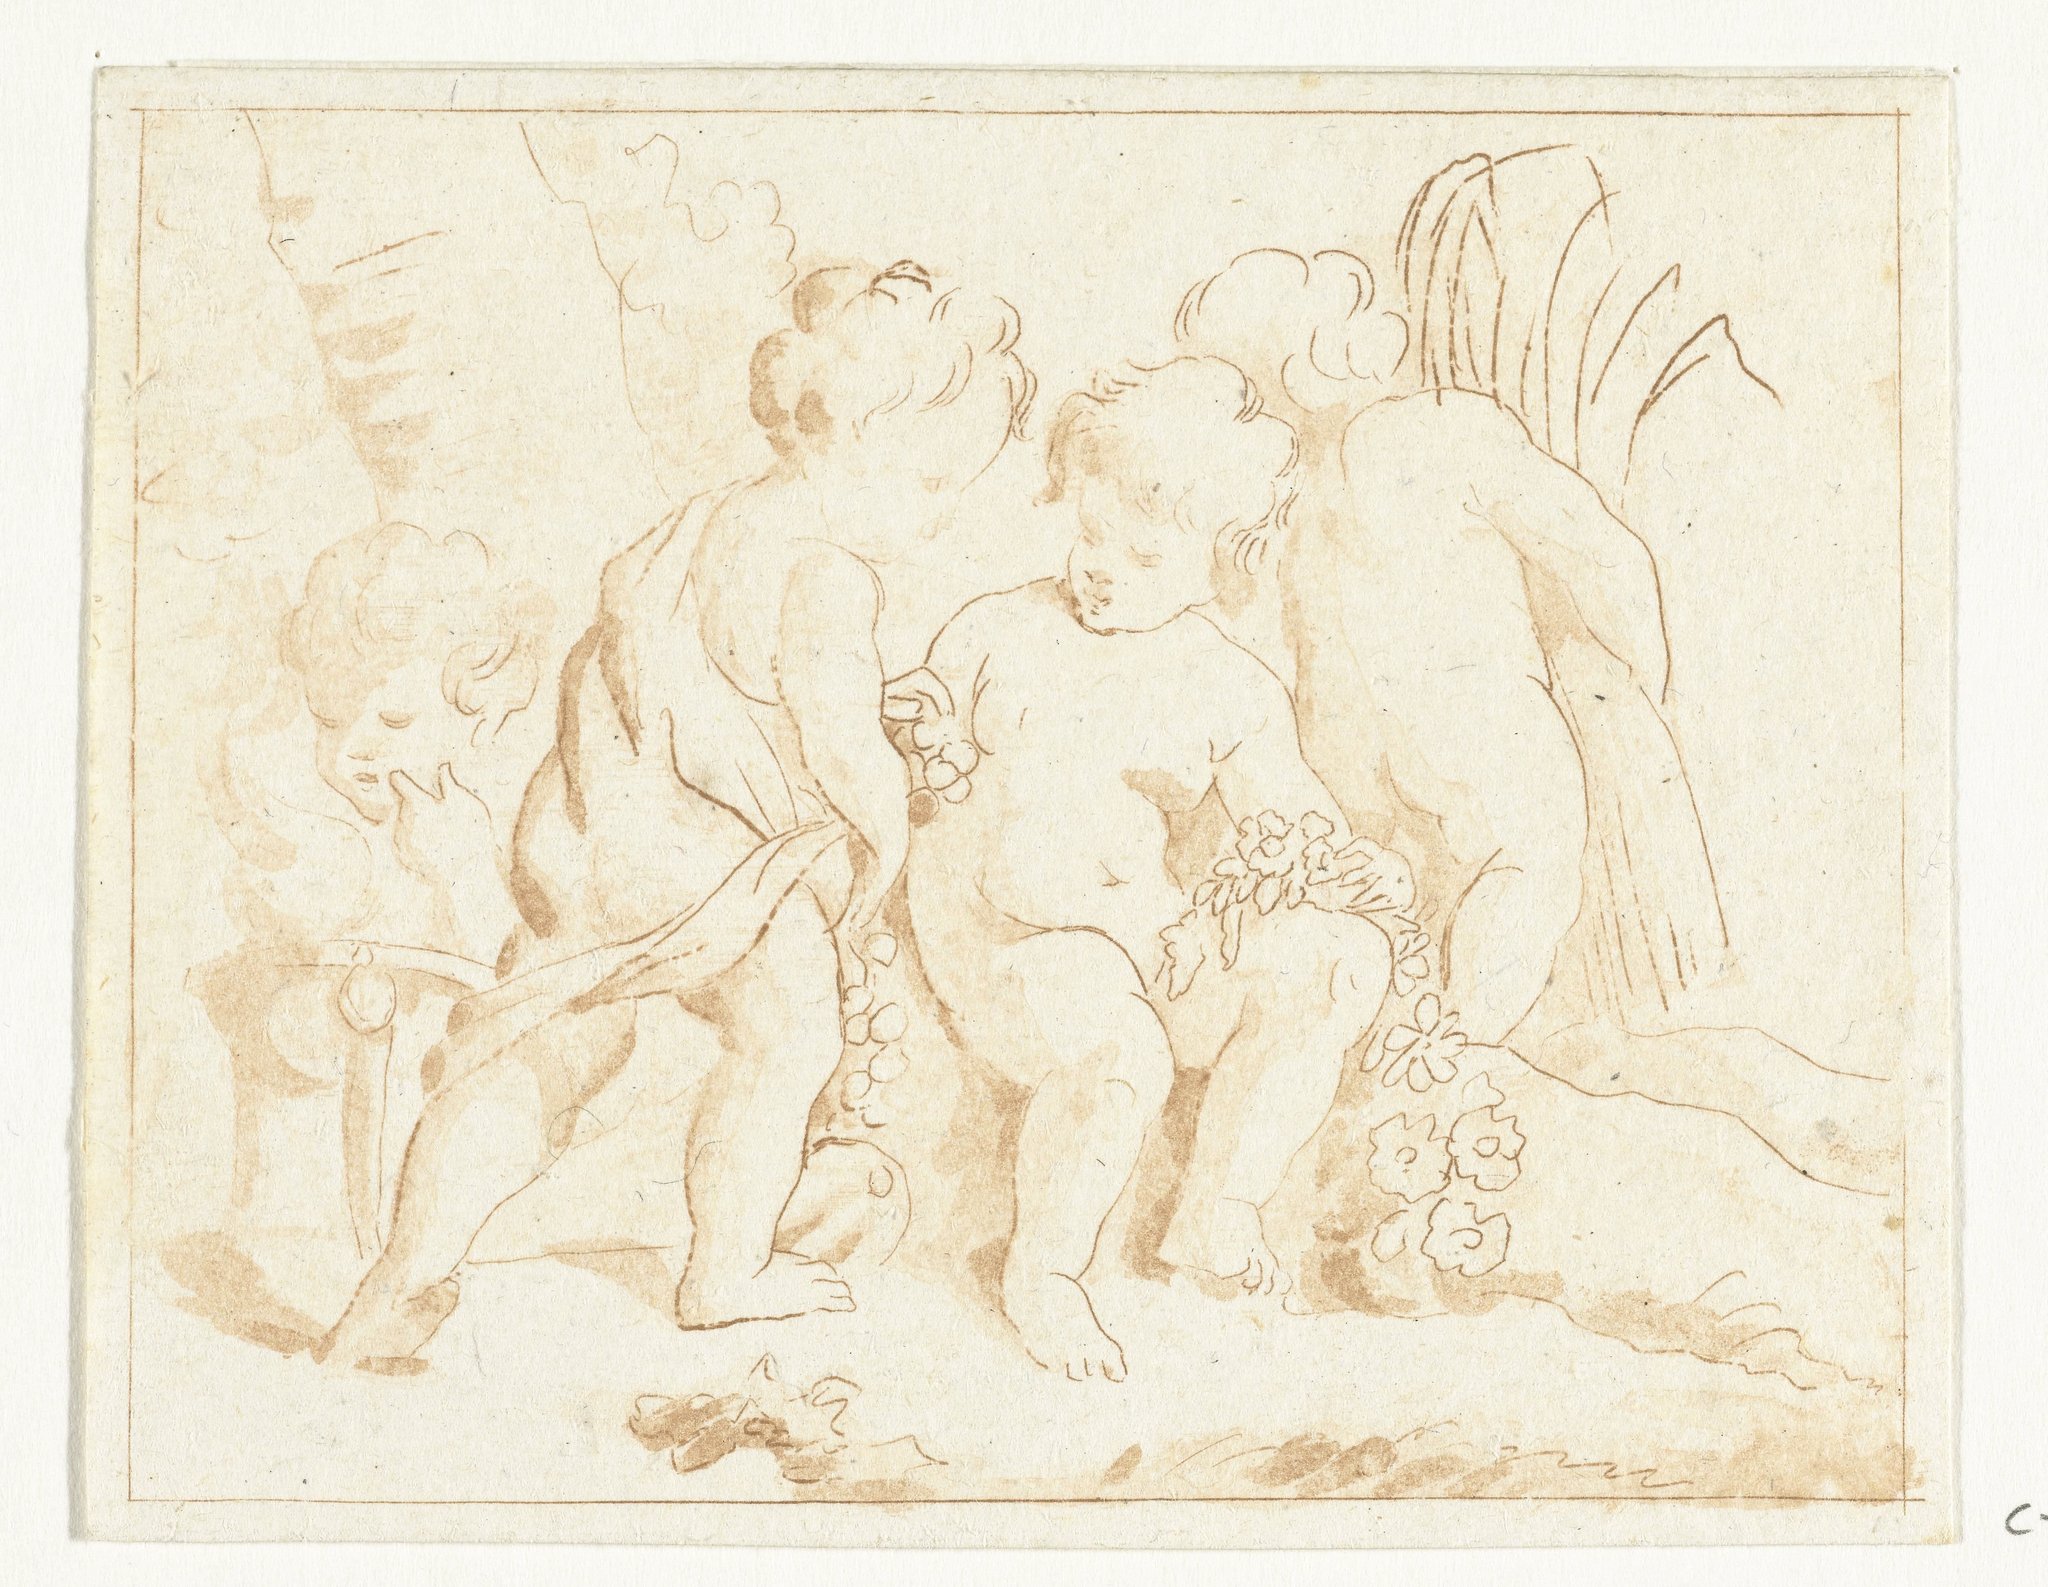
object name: print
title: Vier seizoenen voorgesteld door vier kinderen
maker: anthonie van den bos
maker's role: draughtsman, print maker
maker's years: 1763-1838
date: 1778-1838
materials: paper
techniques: printing, printmaking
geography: netherlands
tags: seasons of the year (esp. personifications); 'stagione', 'le quattro stagione dell'anno' (ripa), seasons of the year represented by scenes showing human activities, usually in a landscape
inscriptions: collector's mark: Lugt 2228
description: De Lente met bloemenkrans zit in het midden, rechtsachter de Zomer met korenschoof, links de Herfst die vruchten draagt en de Winter die zich warmt aan een vuur.